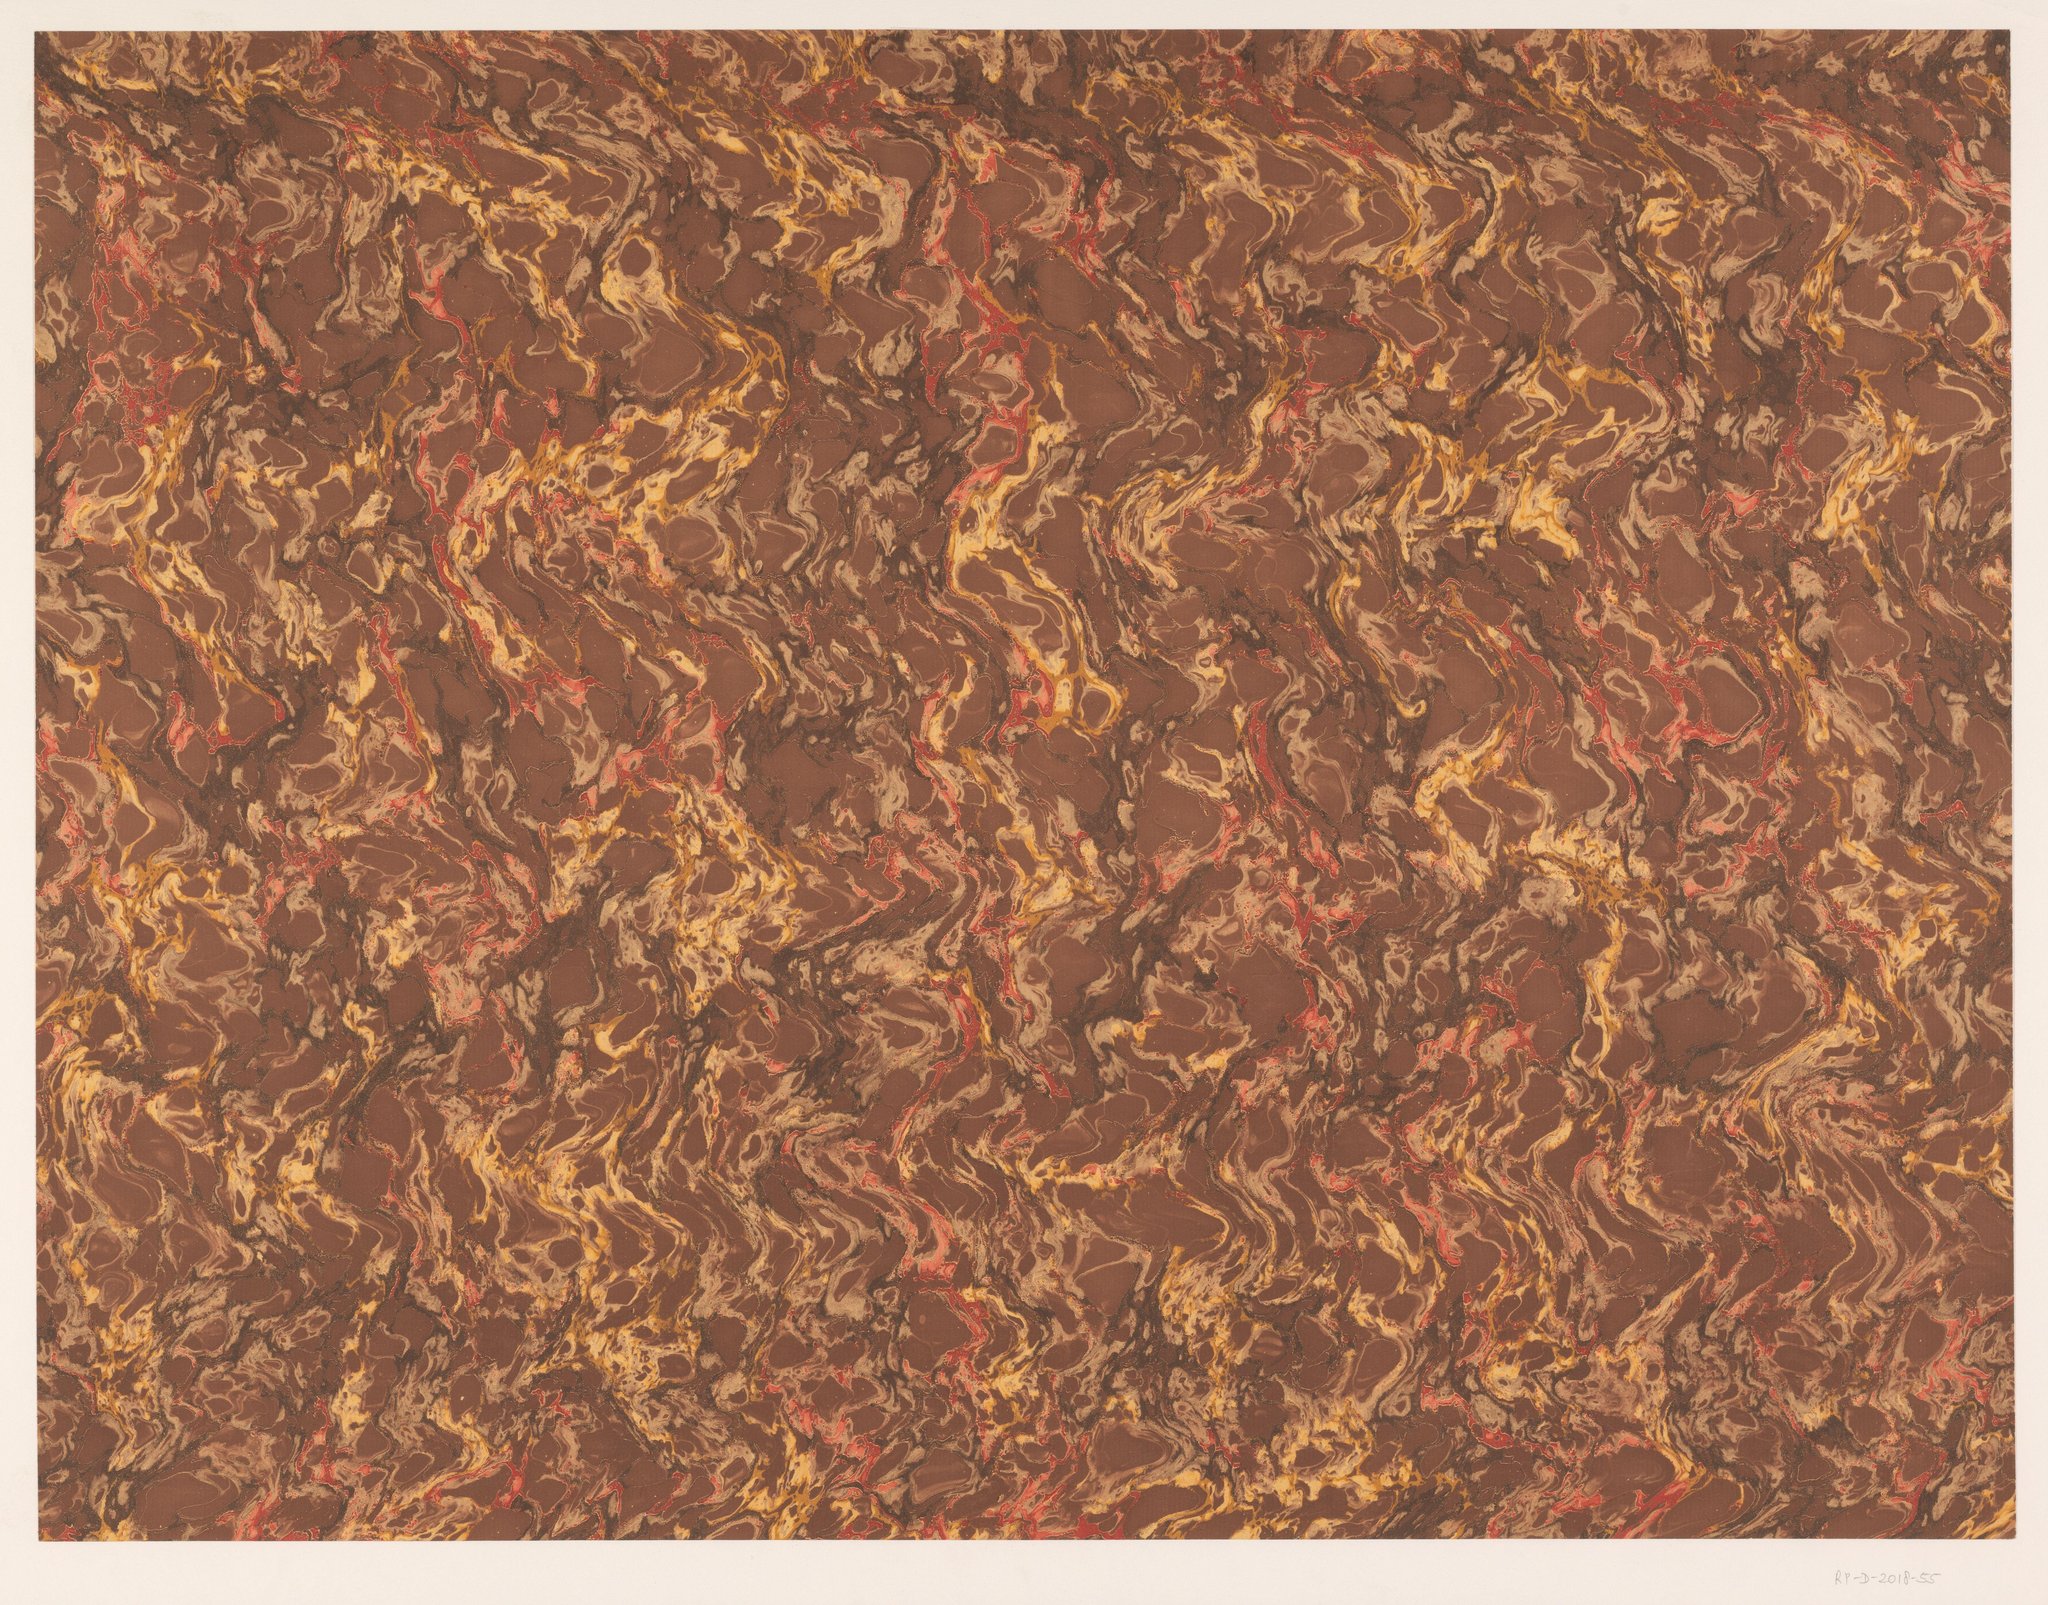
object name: marbled paper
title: Fantasiemarmer in bruin, geel, rood en goud op geel papier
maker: Anonymous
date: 1900-2000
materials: paint, paper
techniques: marbled paper